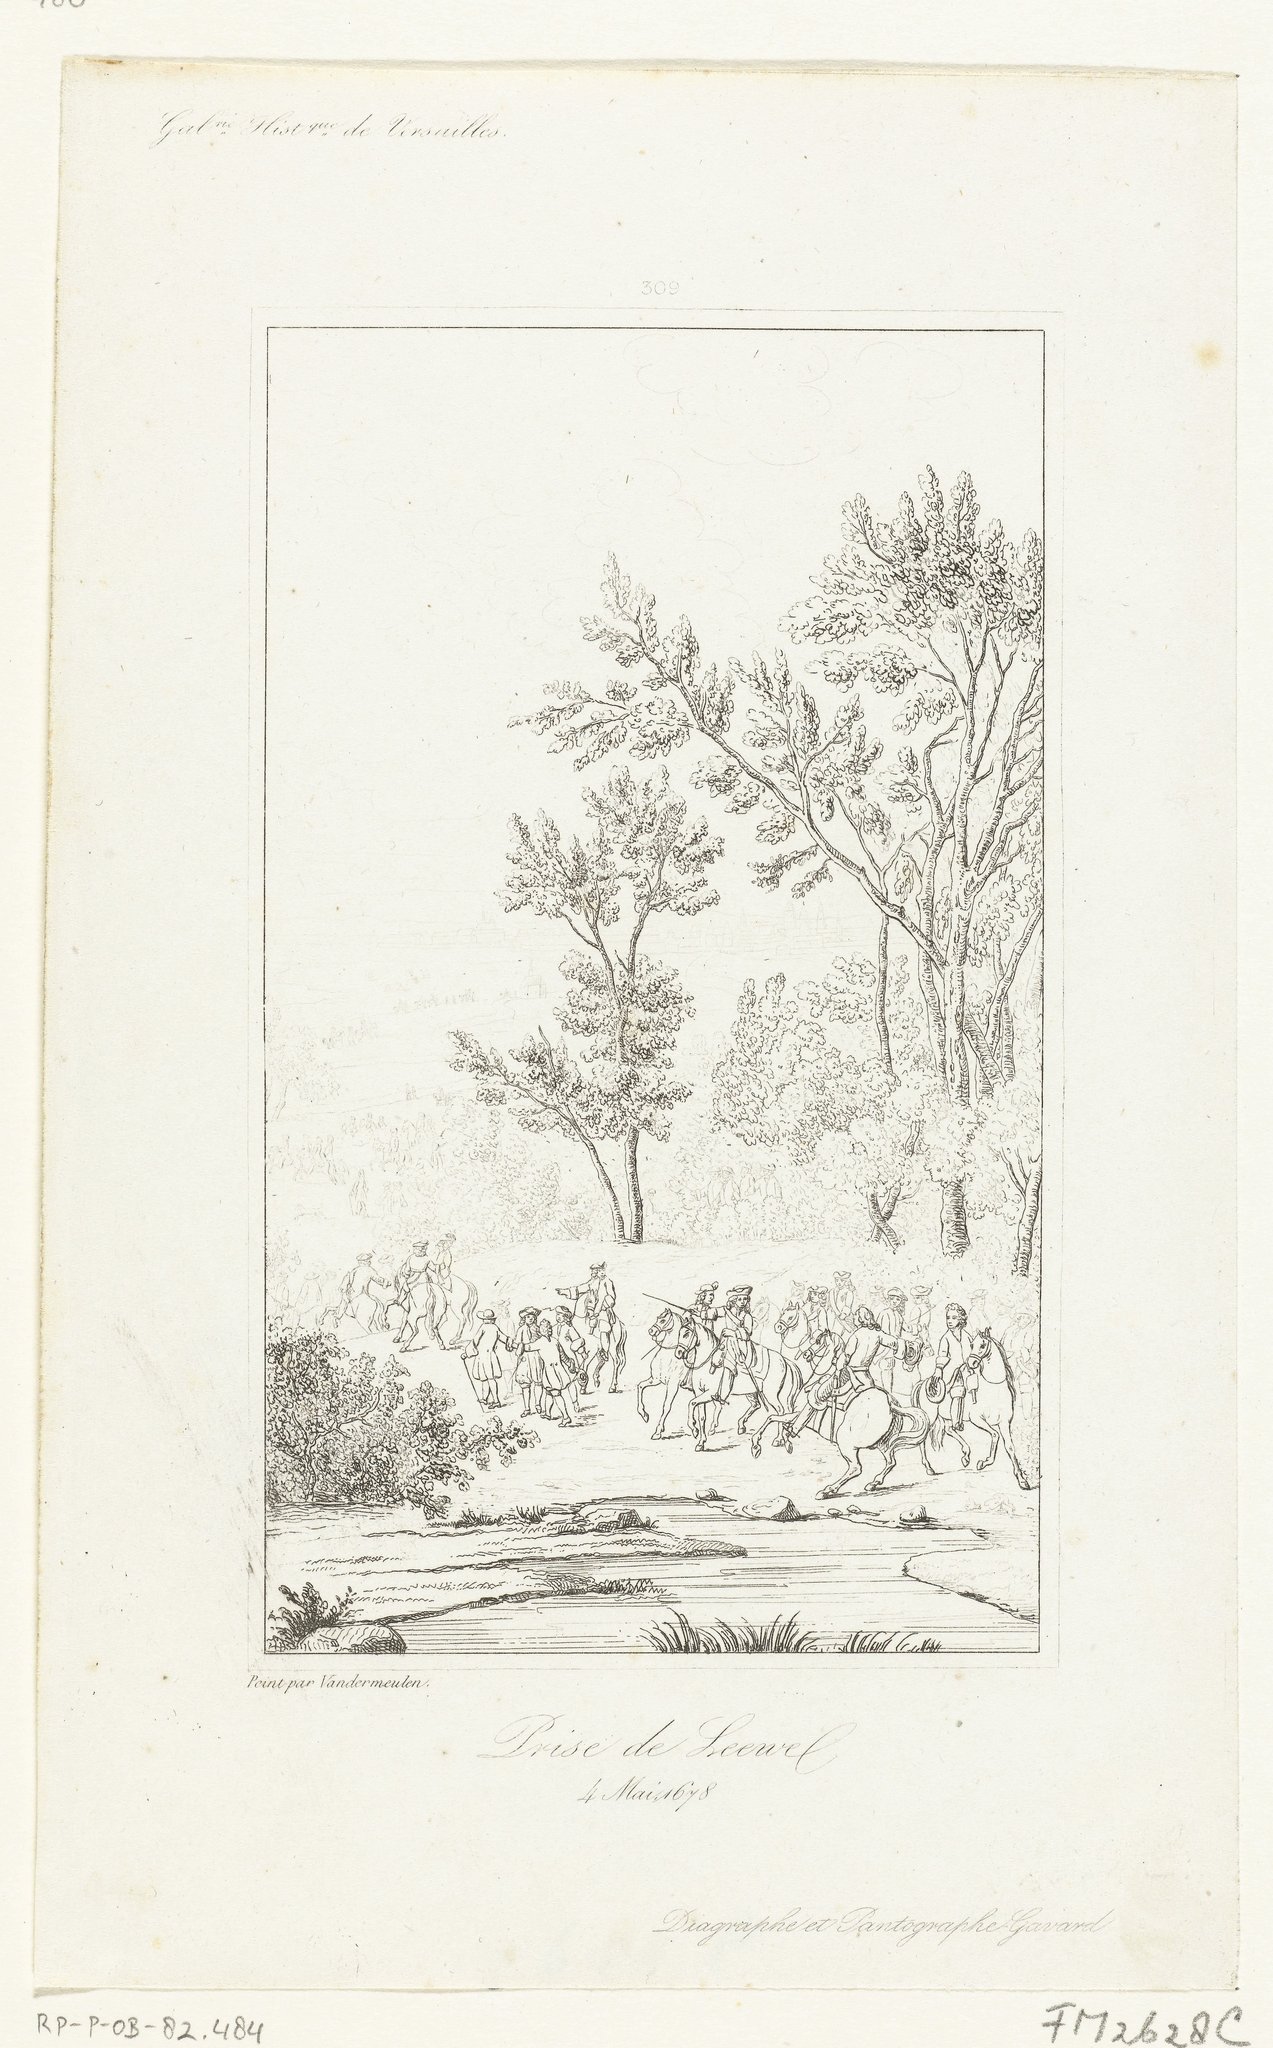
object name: print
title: Prise de Leewel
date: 1835-1840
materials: paper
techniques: lithograph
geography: france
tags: siege, position war, zoutleeuw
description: Gebruikt als illustratie in: C. Gavard, Galeries historiques de Versailles, collection de gravures réduites d'après les dessins originaux du grand ouvrage, Parijs 1840, nr. 309. Niet in Frederik Muller; door het RPK toegevoegd nummer. Op de prent vermeld: Diagraphe et Pantographe Gavard.